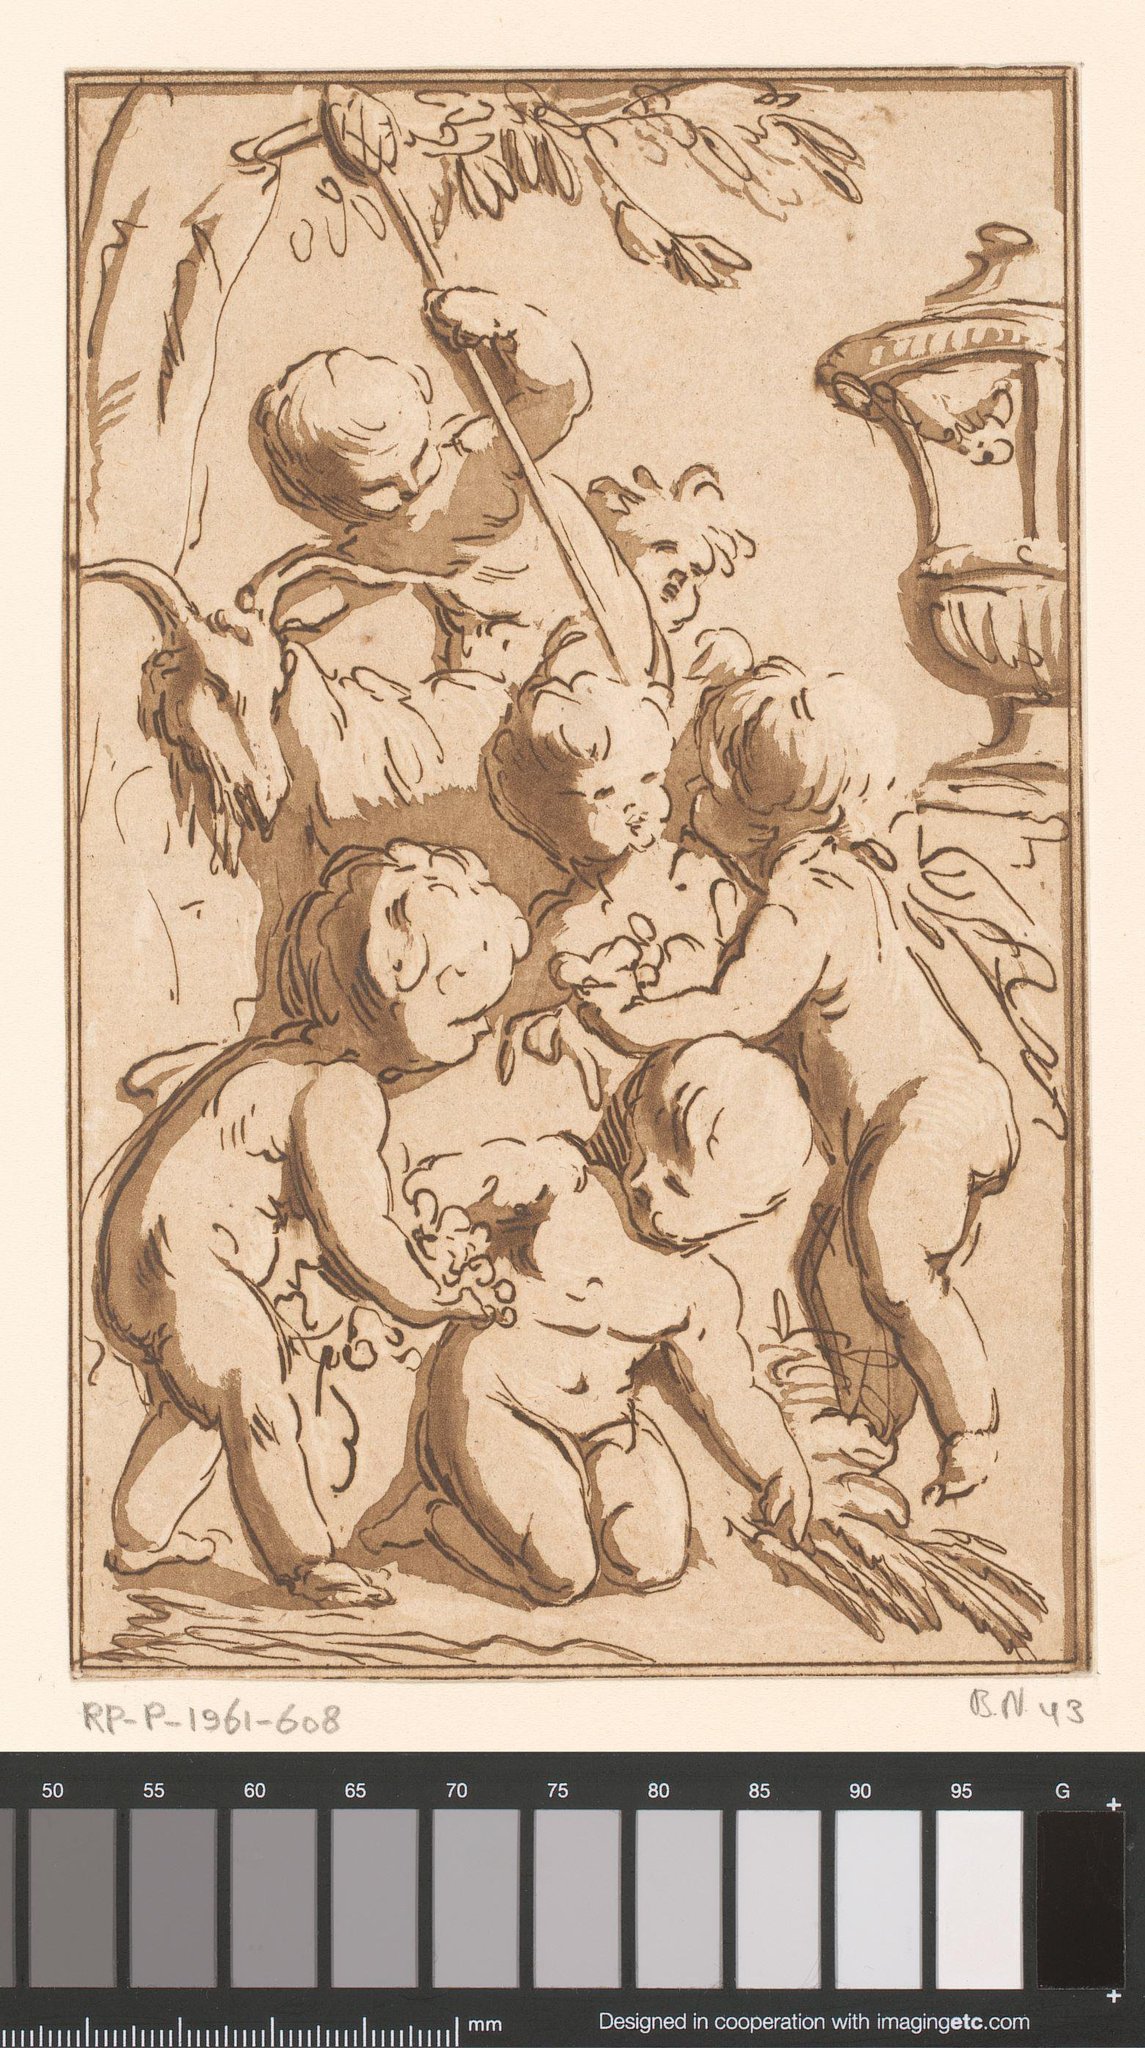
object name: print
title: Bacchanaal van Amors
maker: françois philippe charpentier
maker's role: print maker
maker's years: 1734-1817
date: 1772-1817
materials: paper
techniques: aquatint, etching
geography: france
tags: cupids: 'amores', 'amoretti', 'putti'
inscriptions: collector's mark: ‘"School voor de grafische vakken te Utrecht"’